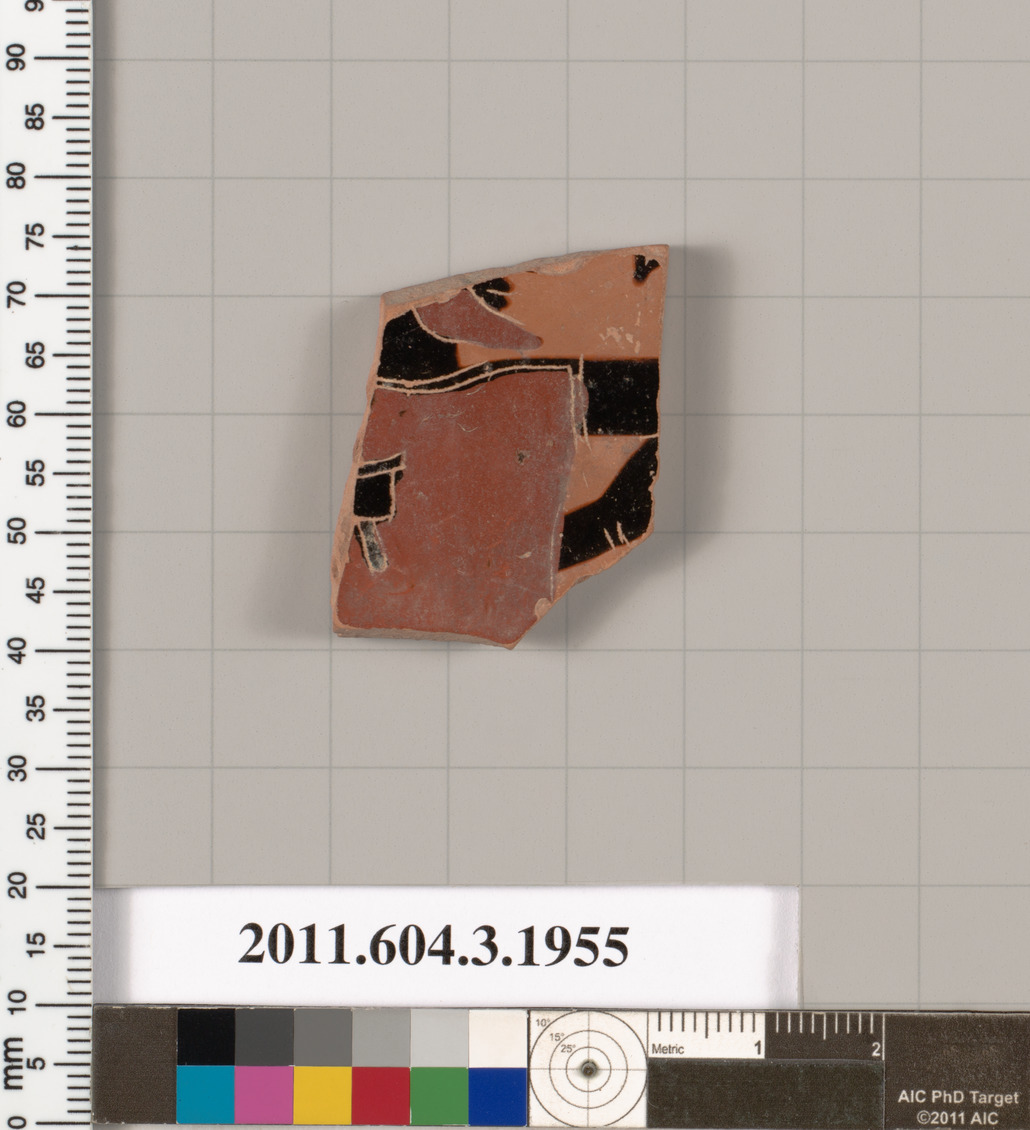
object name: kylix fragment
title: Terracotta fragment of a kylix (drinking cup)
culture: greek, attic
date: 560-550 BCE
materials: terracotta